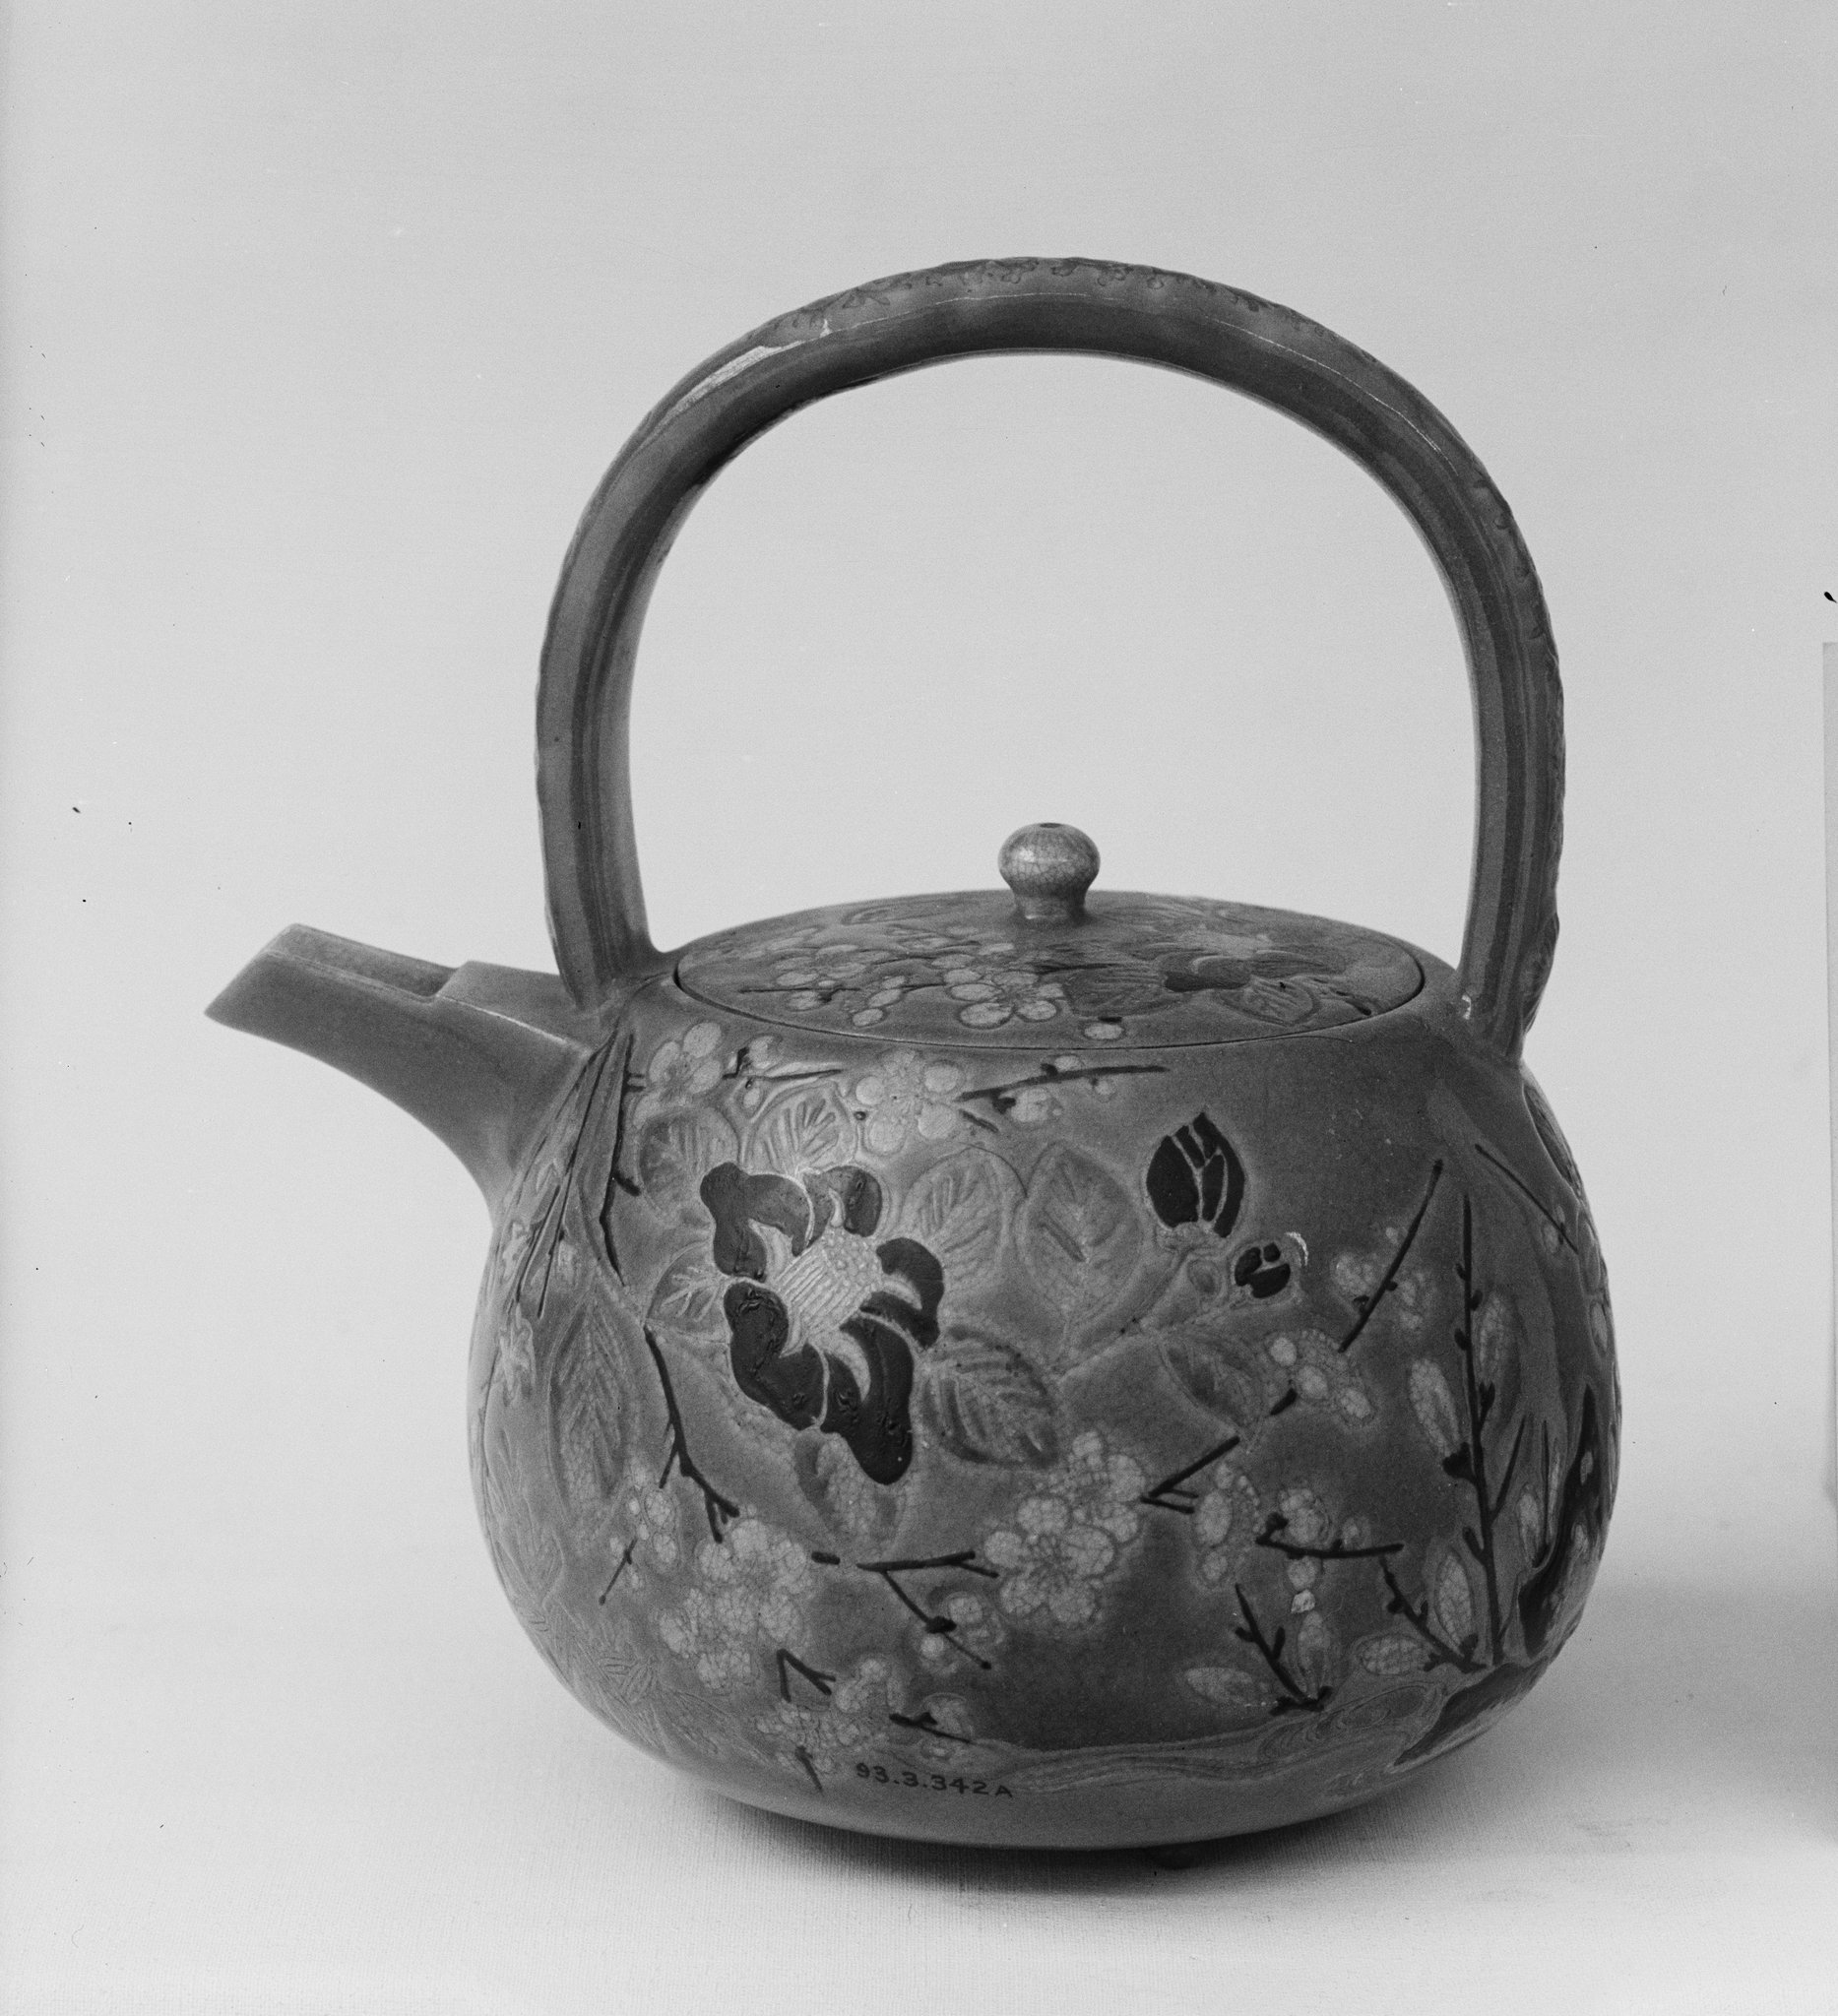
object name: wine bottle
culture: japanese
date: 1780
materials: clay, enamel, glaze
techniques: polychrome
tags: flowers